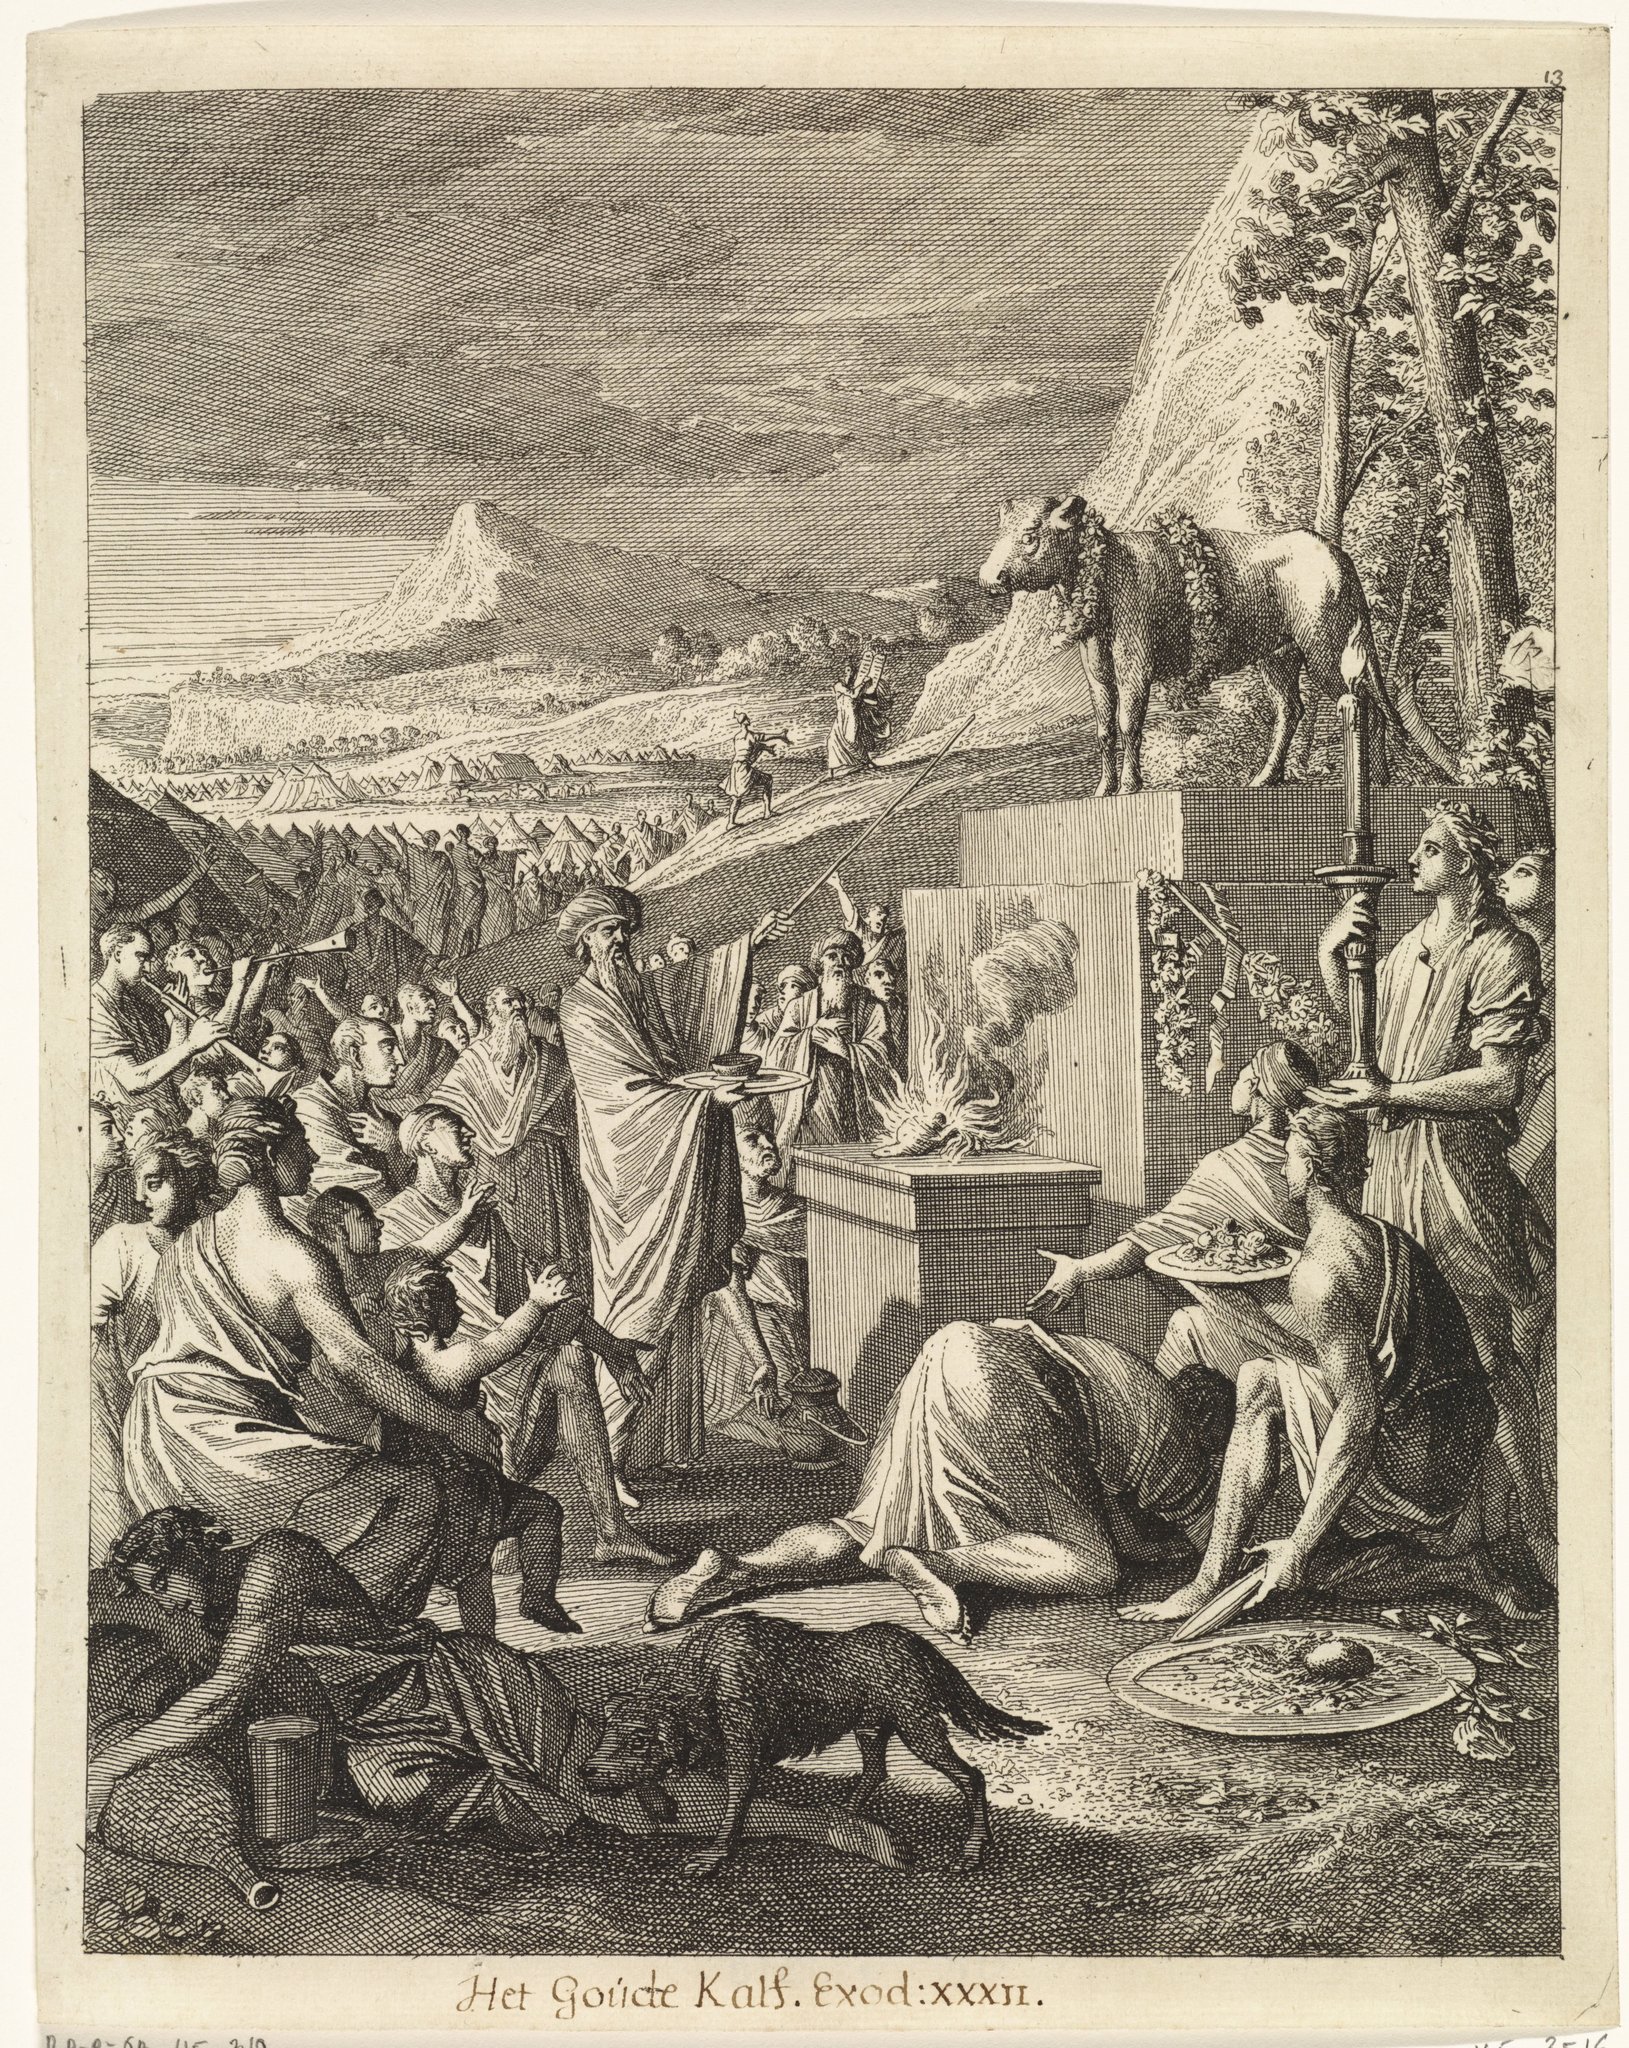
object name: print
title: Aanbidding van het Gouden Kalf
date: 1708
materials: paper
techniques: etching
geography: nuremberg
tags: the people dance around the golden calf ~ exodus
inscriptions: collector's mark: Lugt 2228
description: Proefdruk van een prent welke is opgenomen als illustratie in: Historiae Celebriores Veteris Testamenti. Christoph Weigel, 1708.